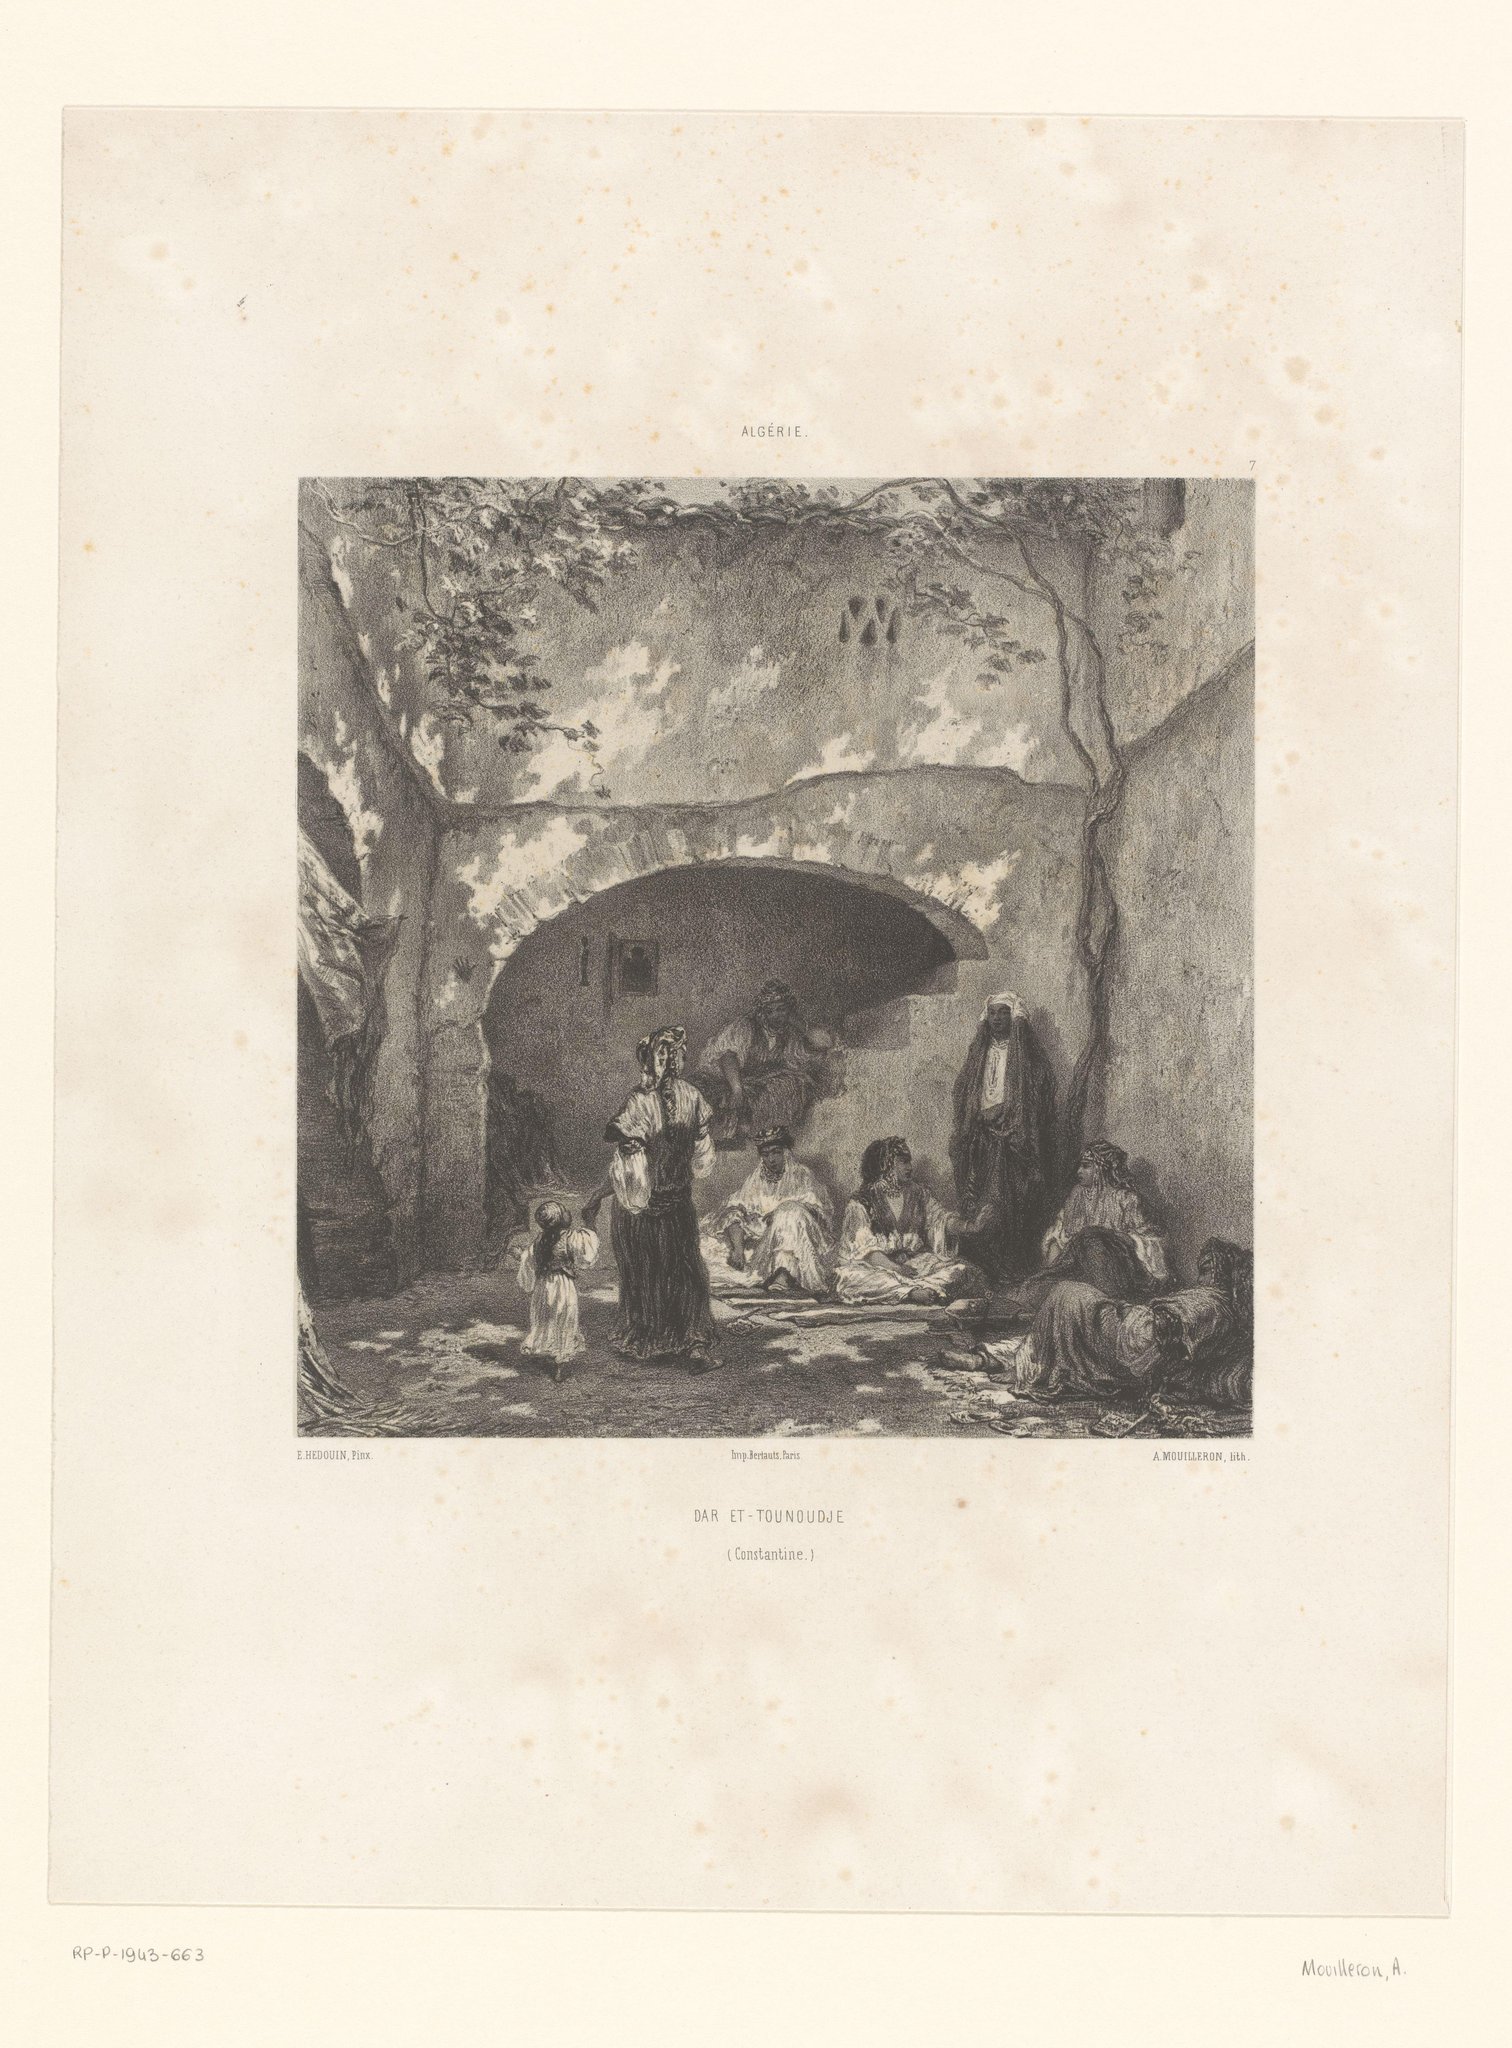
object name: print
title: Algerije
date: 1851-1880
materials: paper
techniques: lithograph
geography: paris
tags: adult woman, child, courtyard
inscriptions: collector's mark: Lugt 2228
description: Serietitel 'L'orient artistique et pittoresque' gebaseerd op verwantschap met andere prenten.